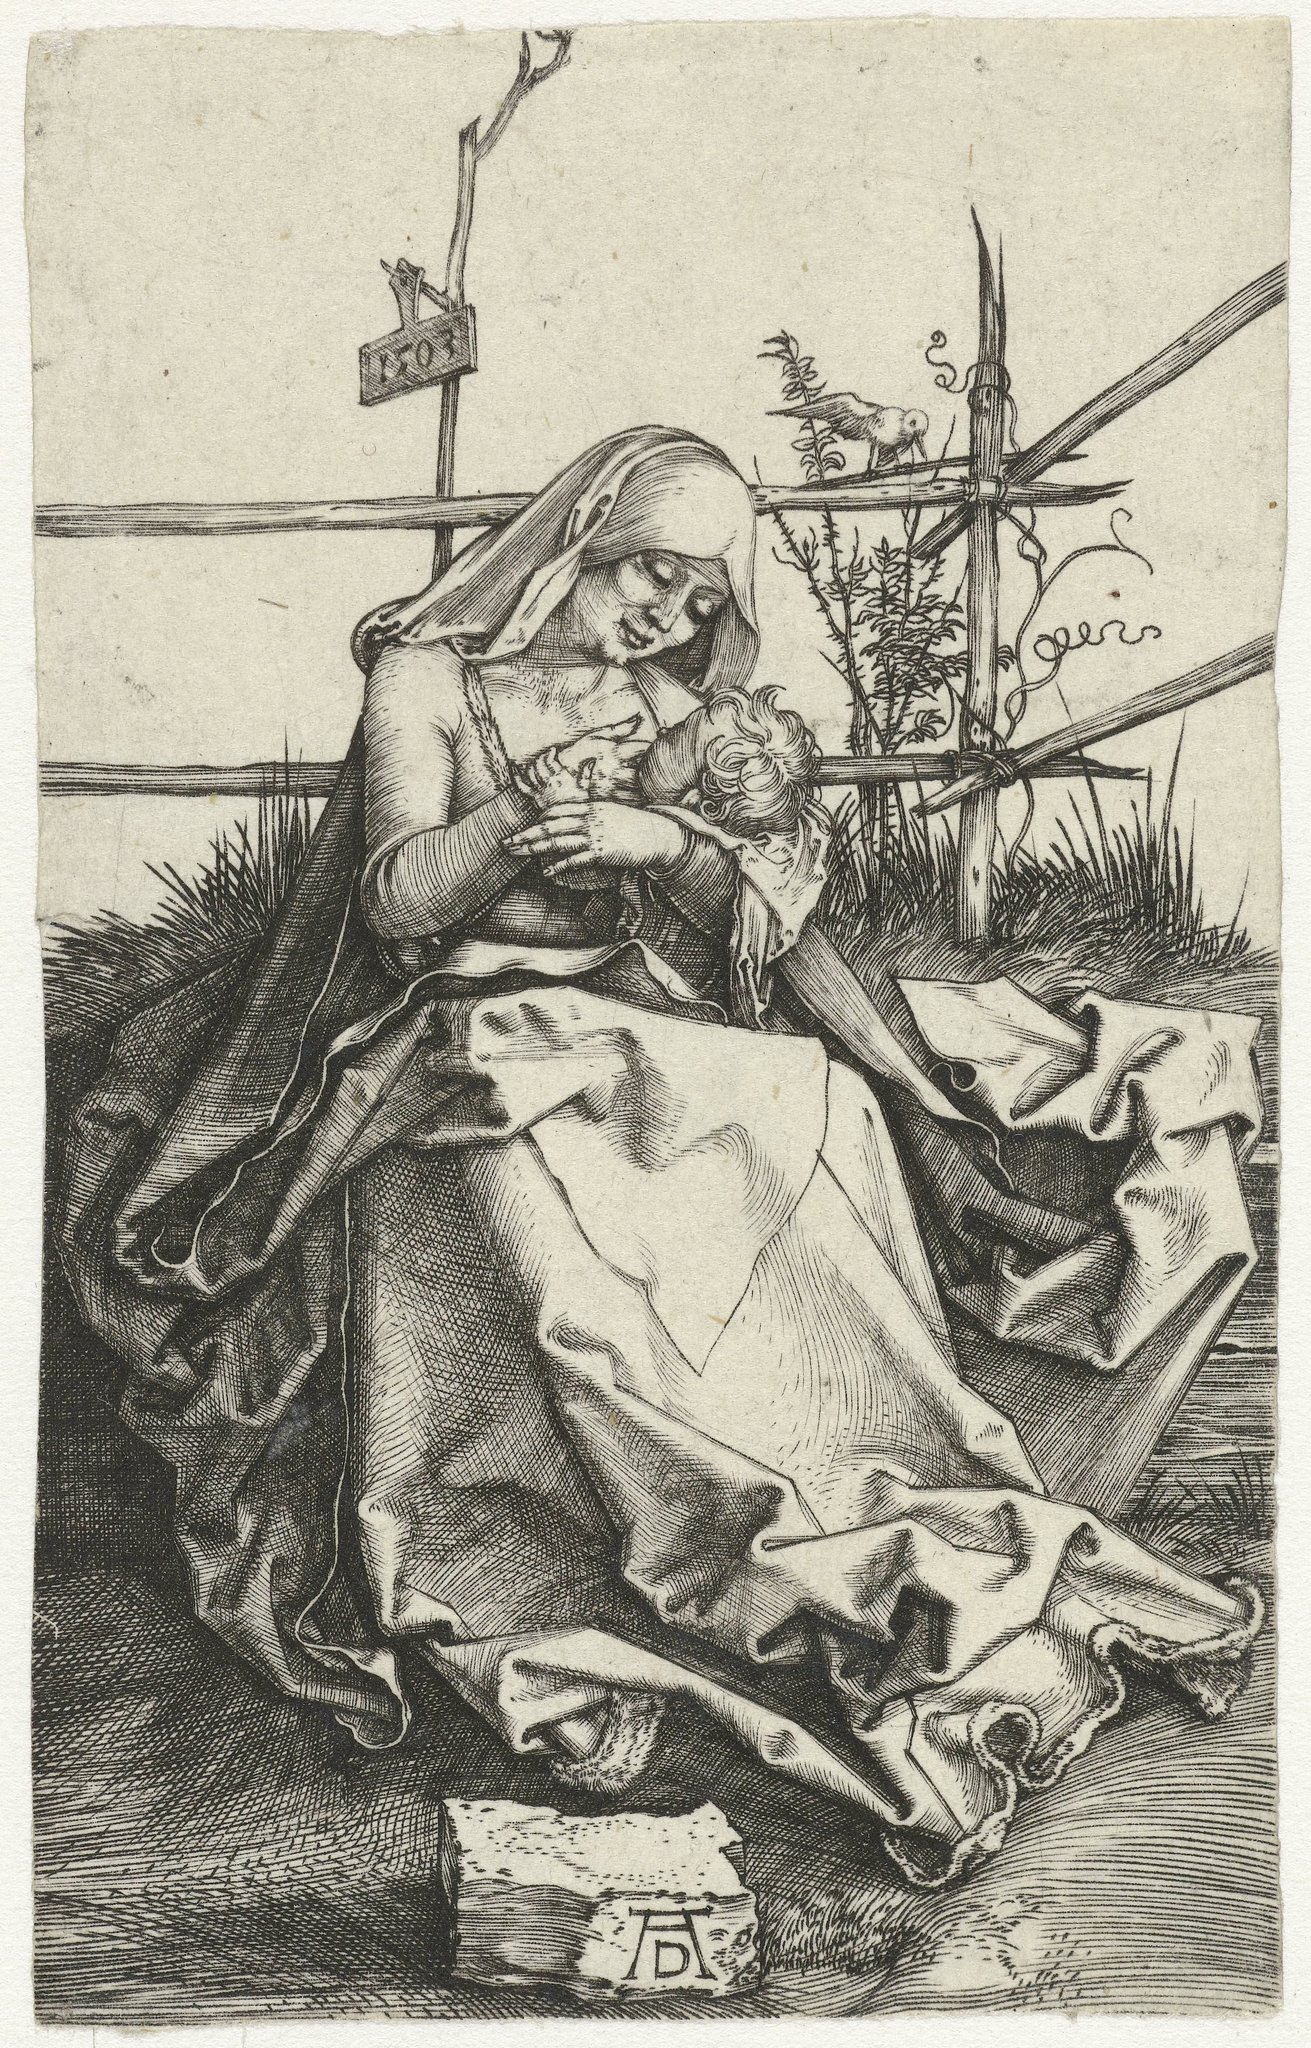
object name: print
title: Maria met kind aan de borst bij een hek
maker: albrecht dürer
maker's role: draughtsman, painter, print maker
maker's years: 1471-1528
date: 1503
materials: paper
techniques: engraving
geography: nuremberg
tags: christ-child suckling, or beginning to suckle, e.g. mary uncovering her breast ~ madonna-representations, mary sitting or enthroned, the christ-child in front of her in her lap (or in front of her bosom)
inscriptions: collector's mark: Lugt 2228a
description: Maria zit op het gras bij een houten hekje en zoogt het Christuskind aan de linkerborst.